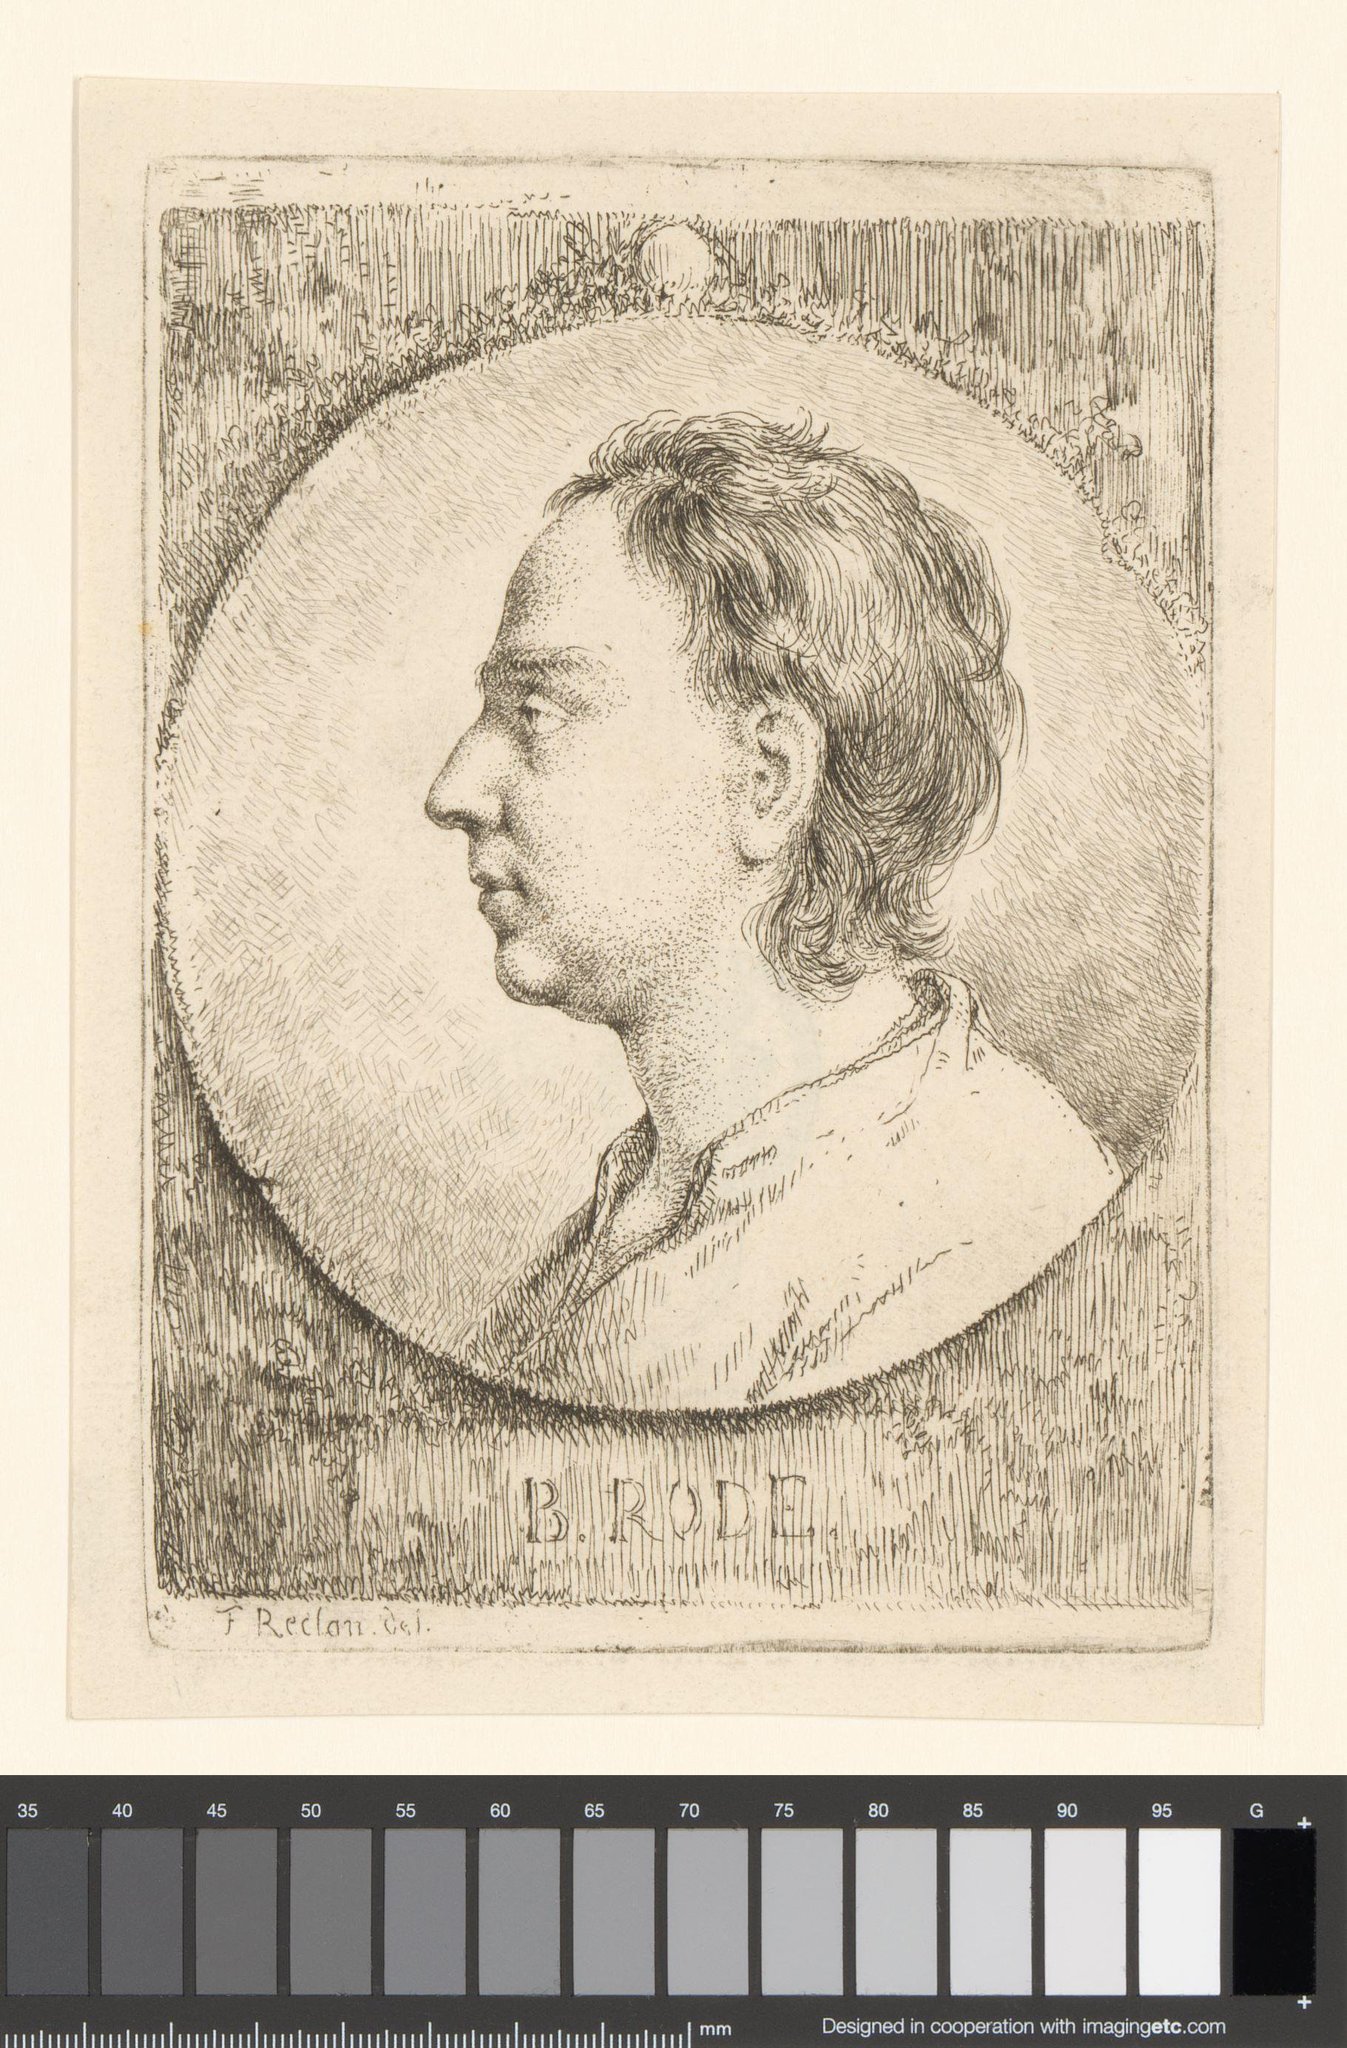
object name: print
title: Portret van Christian Bernhard Rode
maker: friedrich reclam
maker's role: painter, print maker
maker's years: 1734-1774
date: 1744-1774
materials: paper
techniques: etching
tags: berlin, print maker, artist, bernhard rode, historical persons, portrait, self-portrait of artist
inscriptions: collector's mark: Lugt 4958, collector's mark: Lugt 2529, collector's mark: Lugt 2228, collector's mark: Lugt 1606